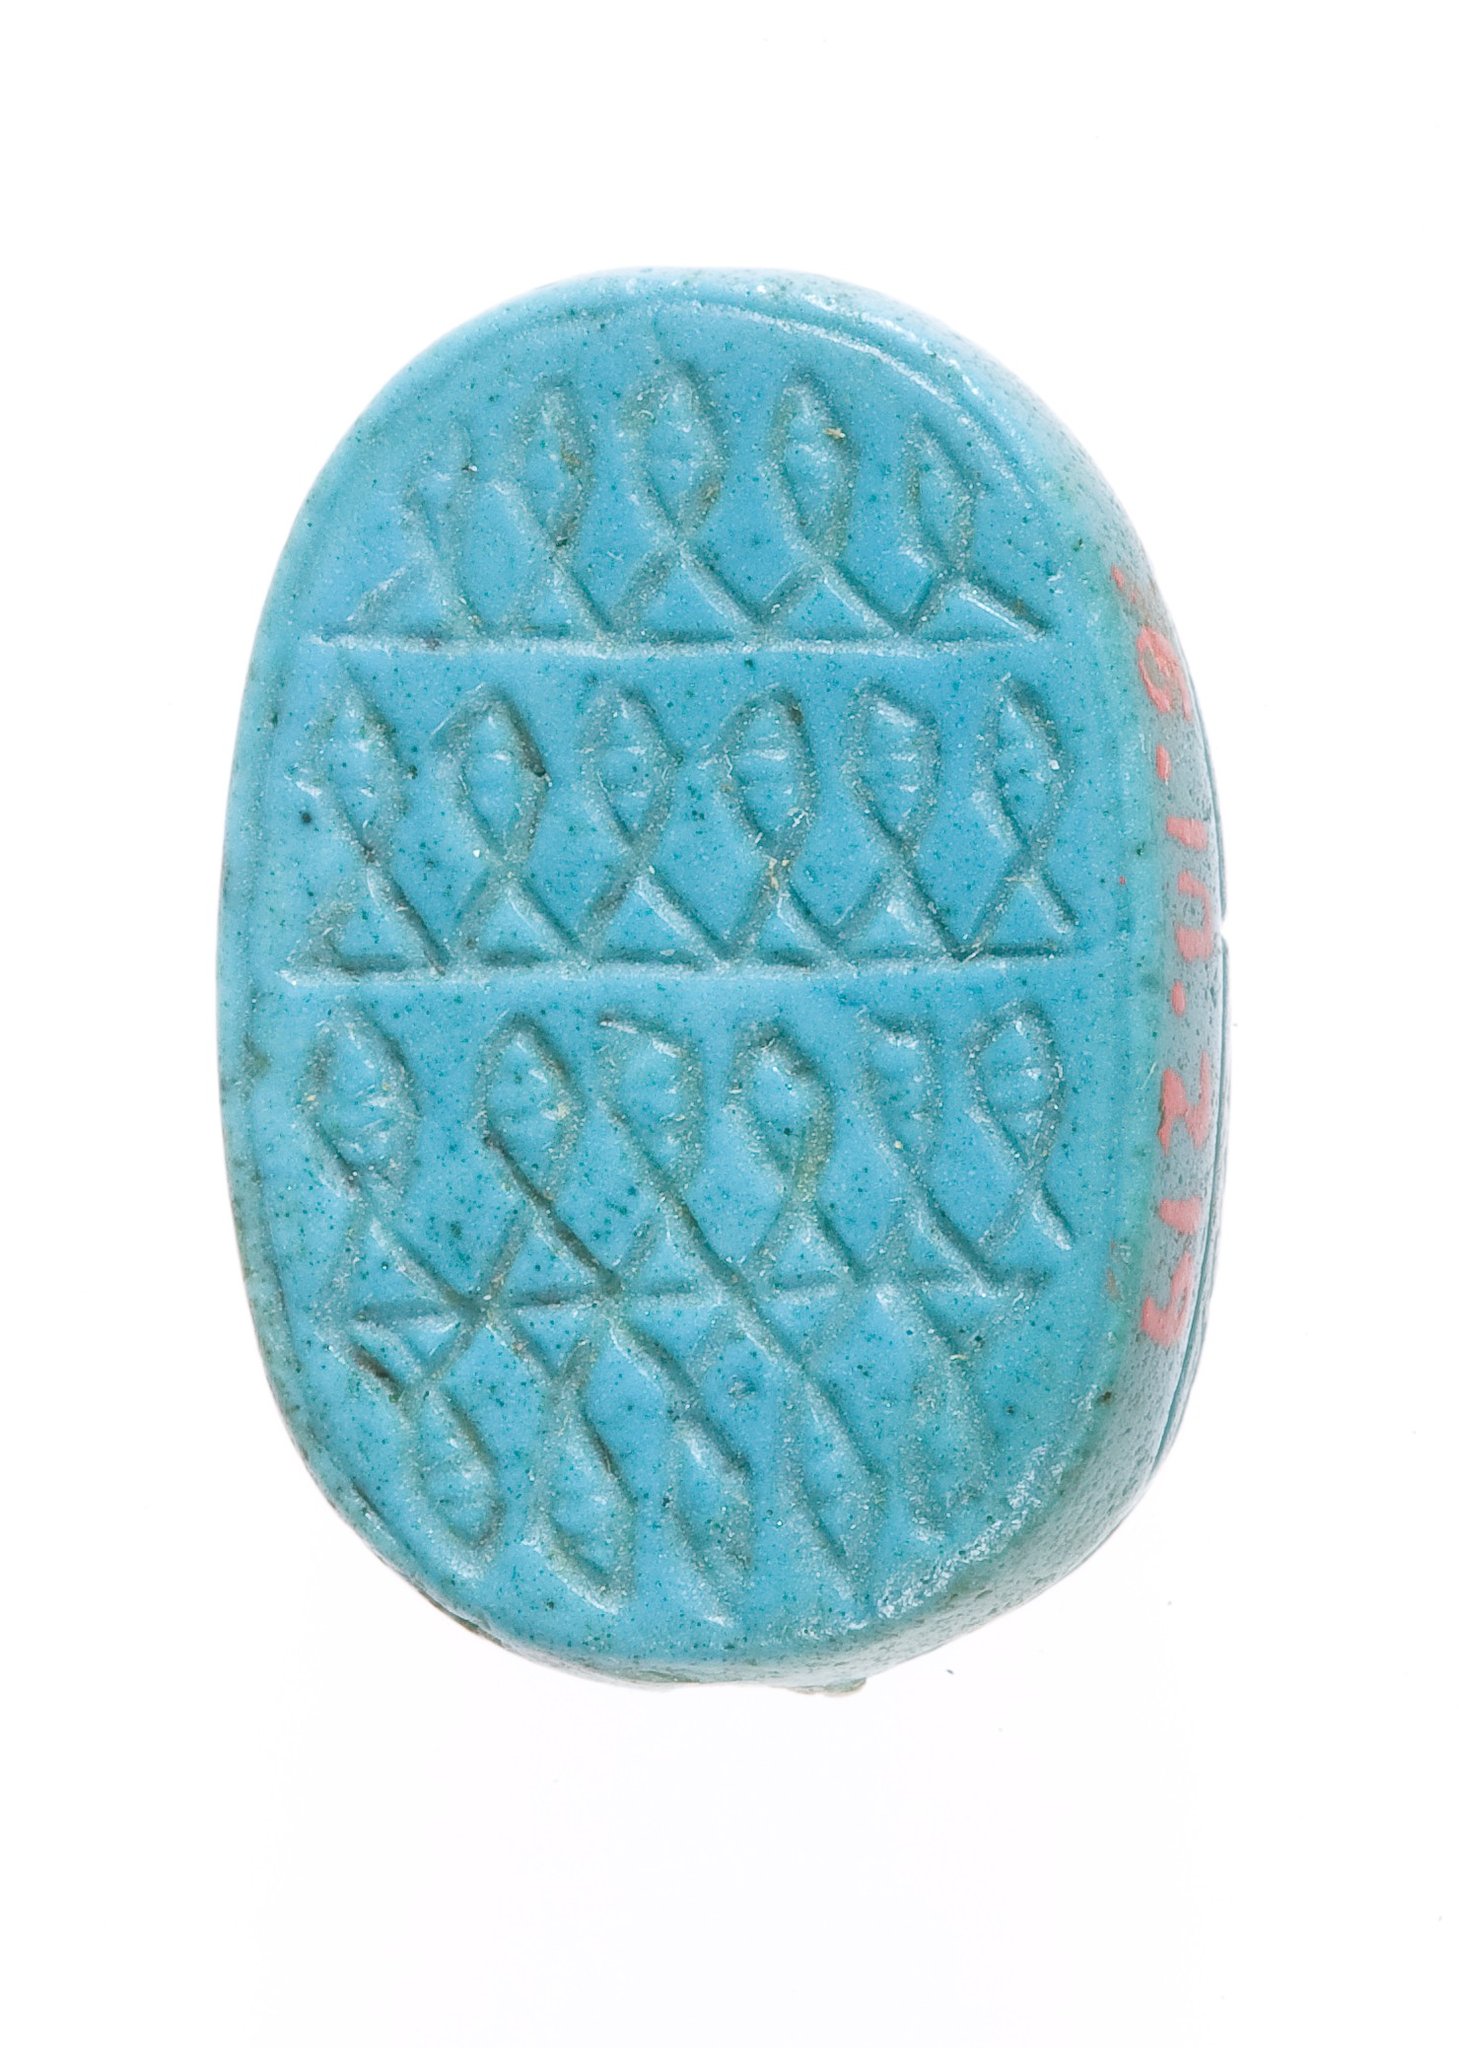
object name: scarab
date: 1640-1550 BCE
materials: stone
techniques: glazing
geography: egypt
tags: scarabs